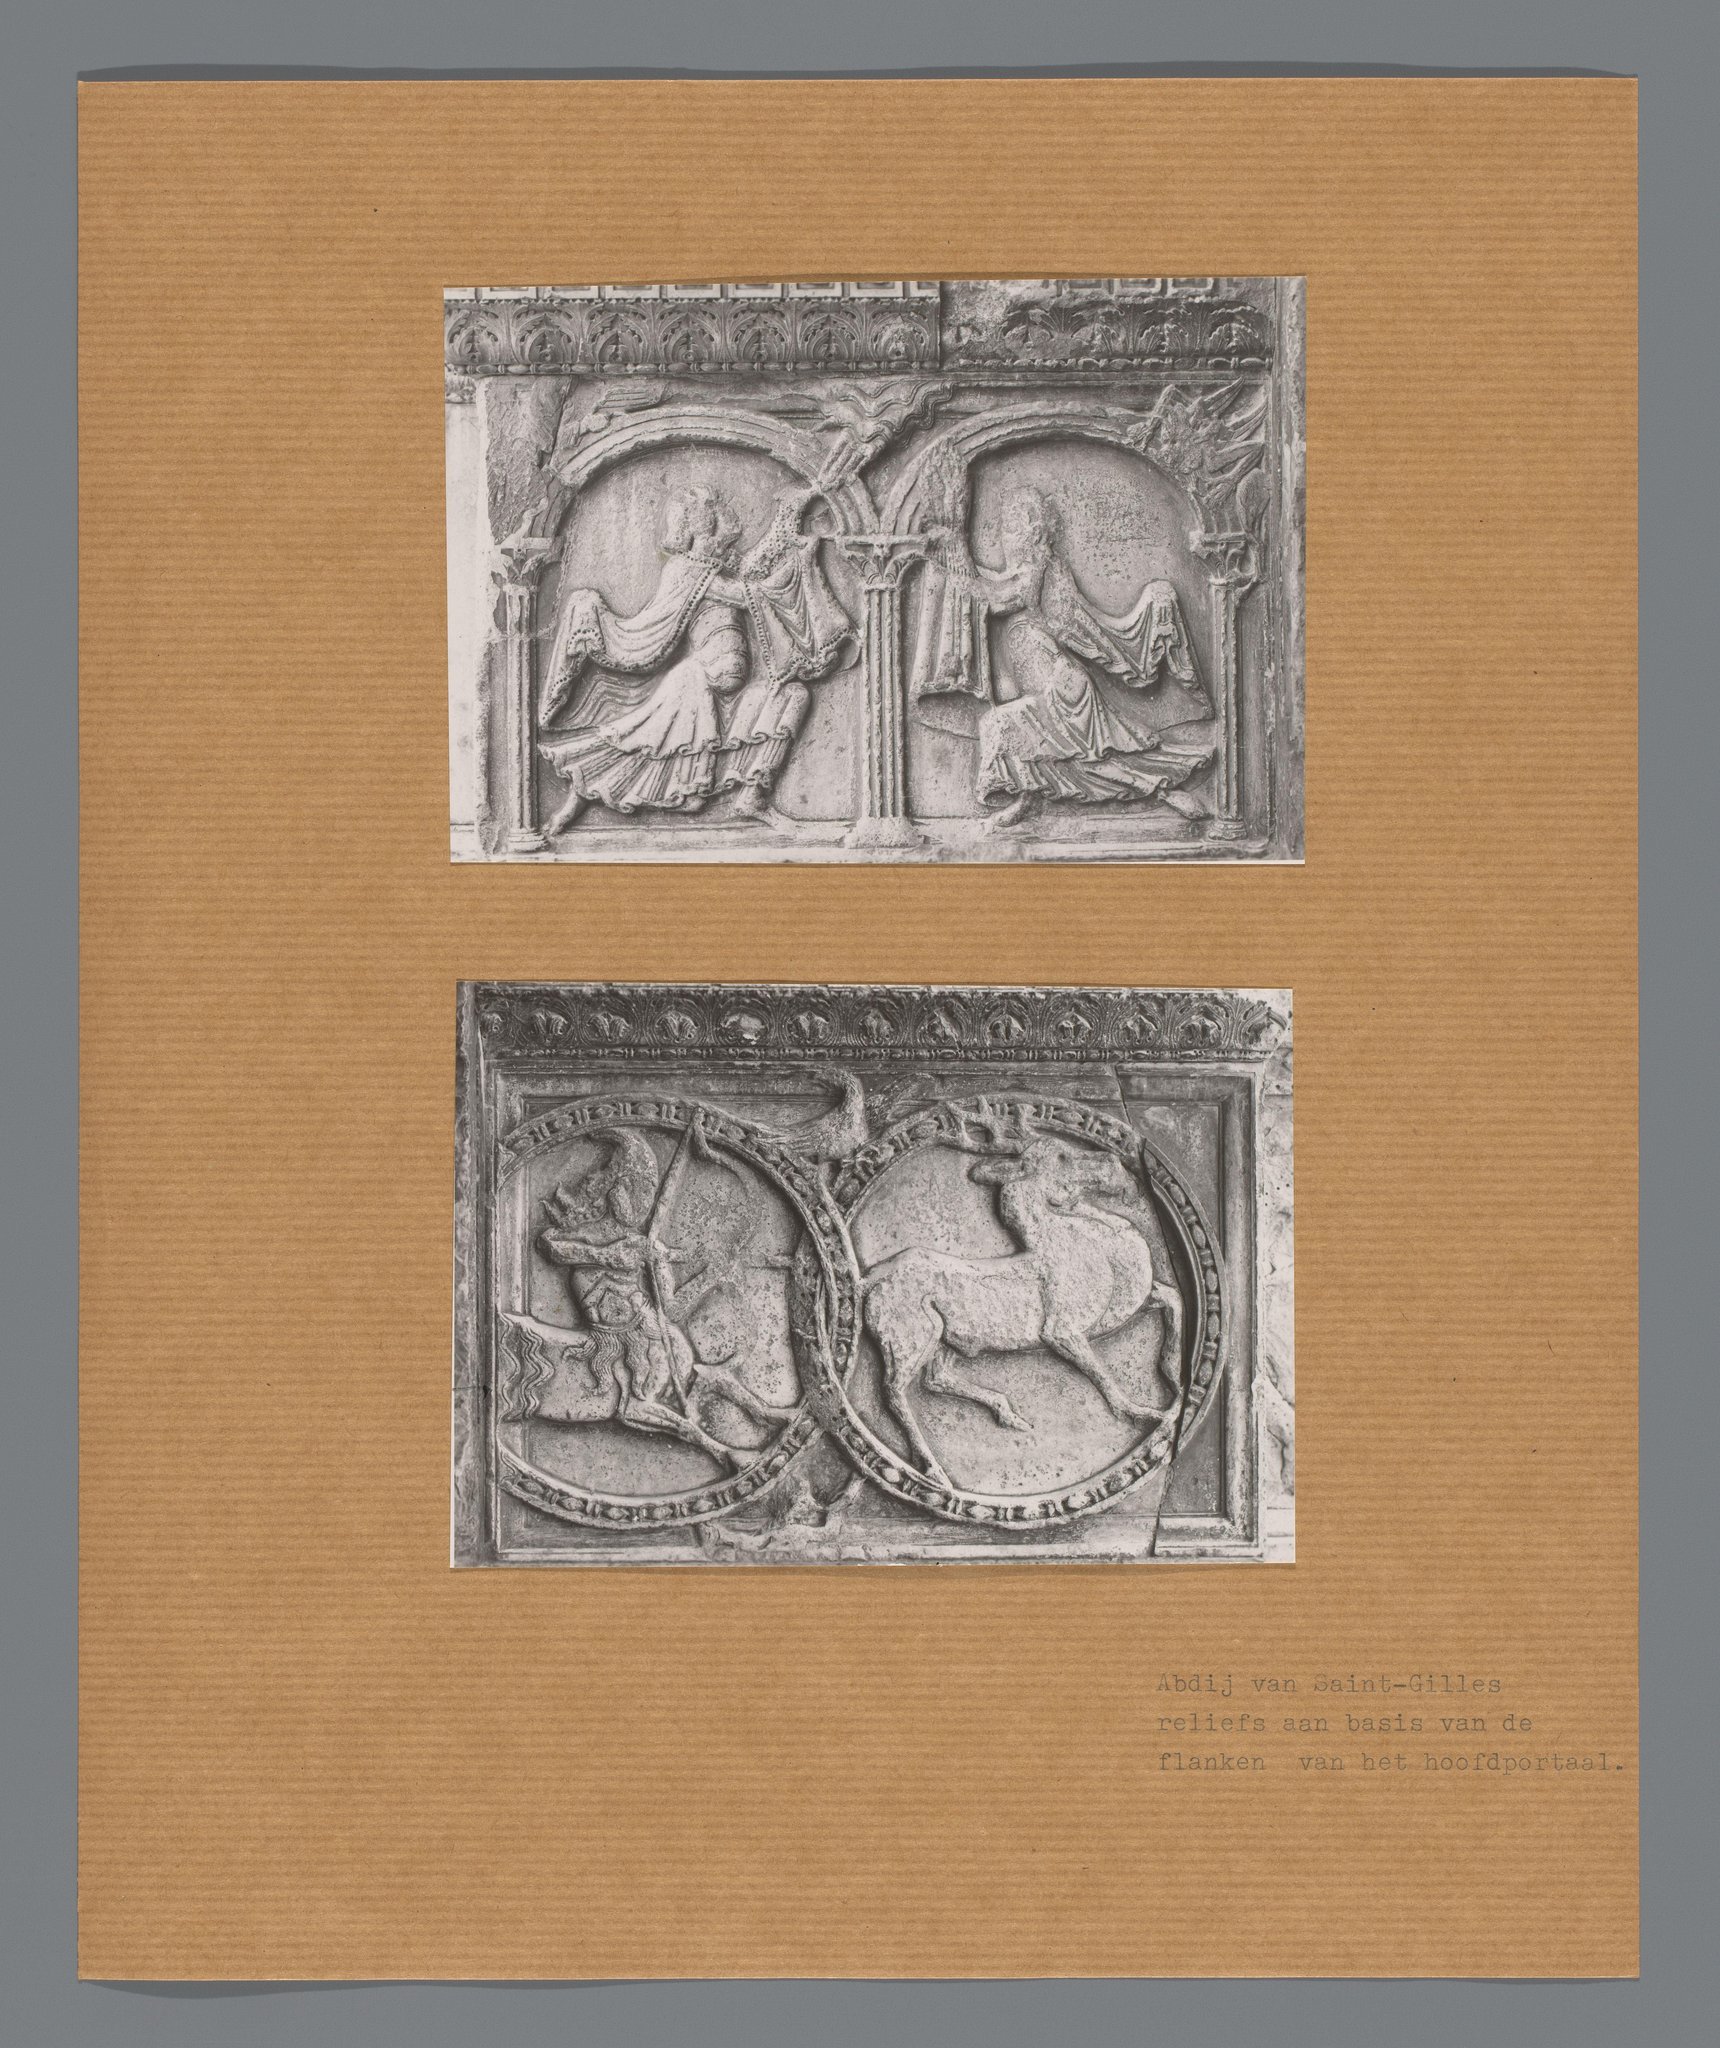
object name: photograph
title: Saint-Gilles, Kirche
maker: Anonymous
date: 1880-1930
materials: photographic support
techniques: gelatin silver print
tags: france